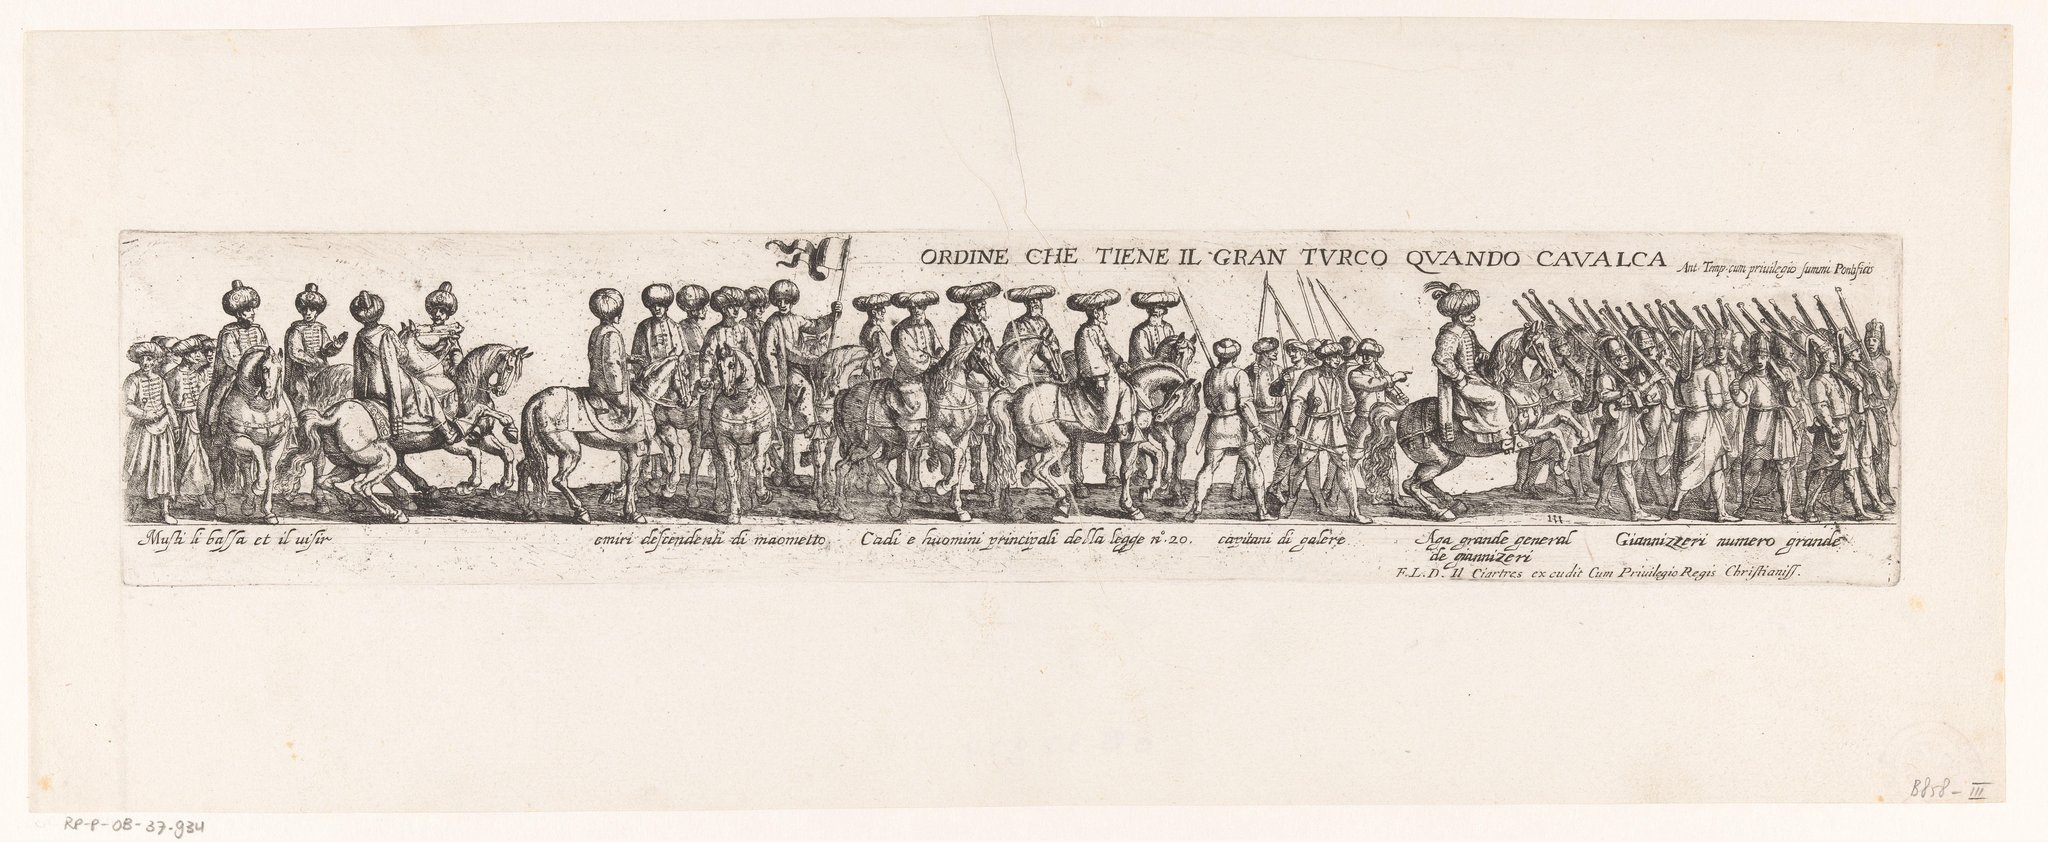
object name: print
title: Cavalcade voor vertrek van een sultan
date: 1599-1647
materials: paper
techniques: etching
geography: italy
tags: ceremonial procession, parade, pageant ~ installation of a ruler, festivities (+ the public ~ festive activities), head-gear: turban, warfare; military affairs (+ cavalry, horsemen)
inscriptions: collector's mark: Lugt 240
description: Deel van een parade met soldaten te paard en voetsoldaten, vanwege het vertrek van een sultan. Bijschriften in het Italiaans in ondermarge.